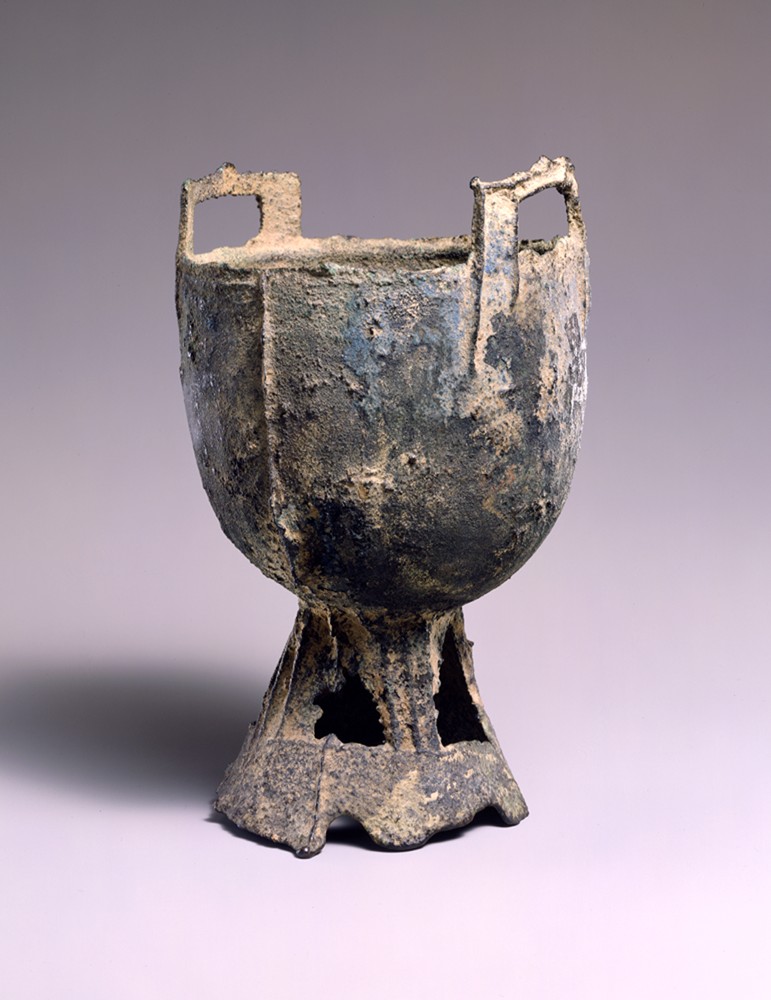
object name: cauldron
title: Cauldron (Fu)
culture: northwest chinese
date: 300-101 BCE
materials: bronze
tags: cauldrons